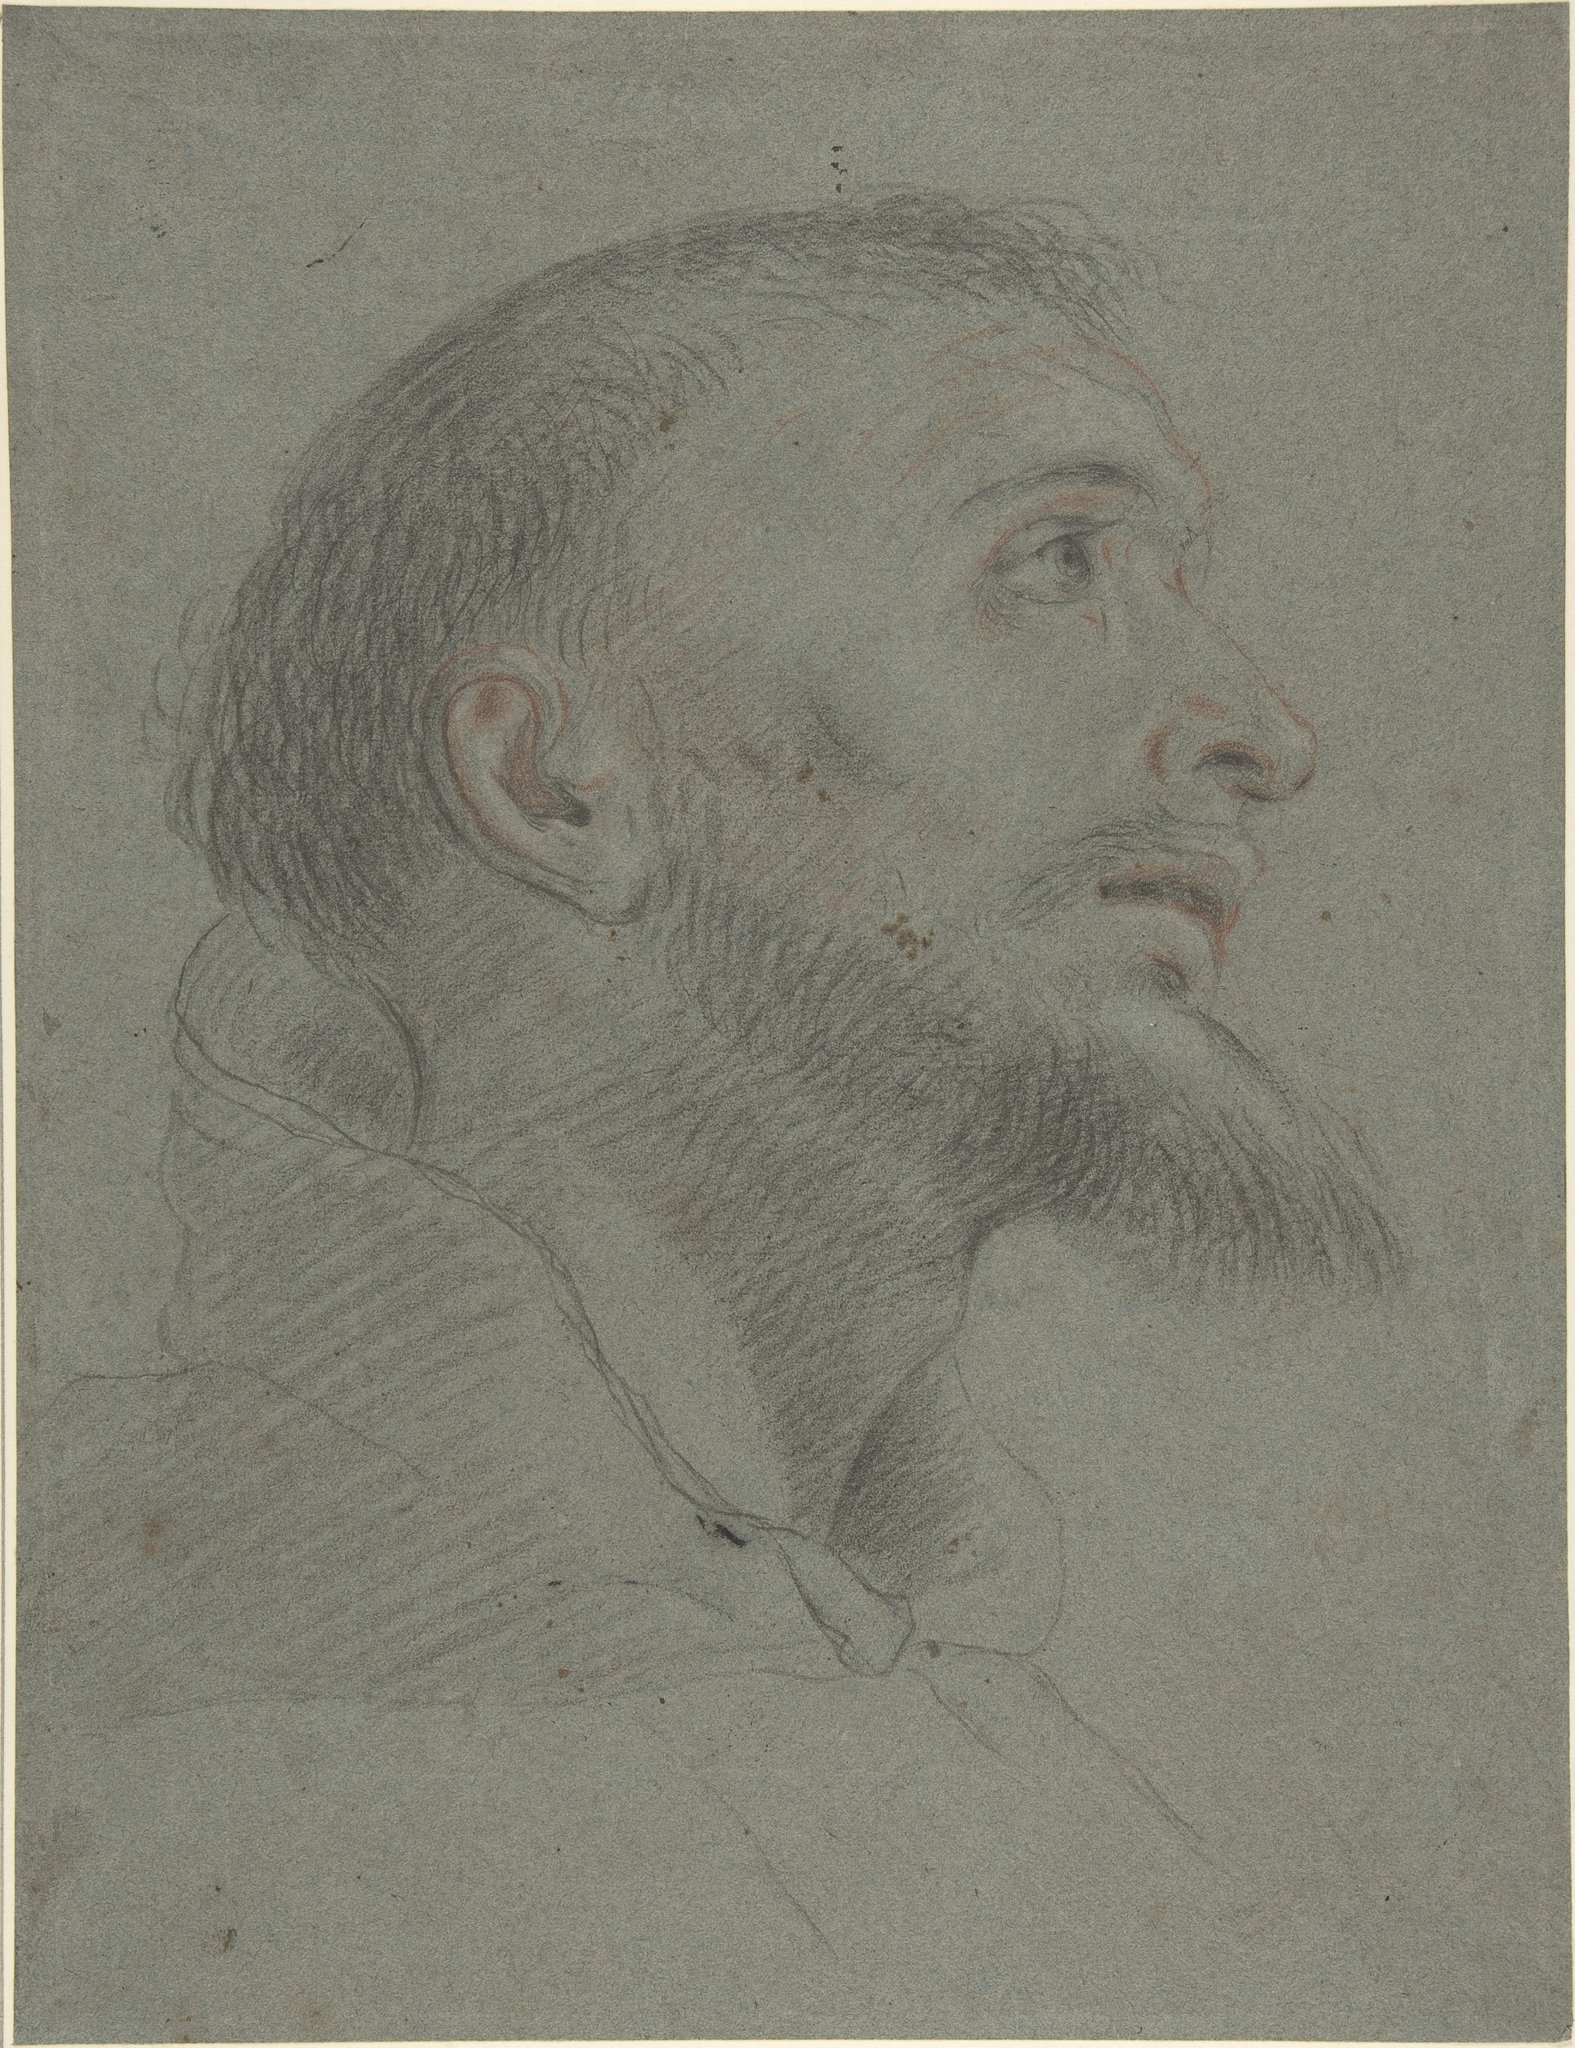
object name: drawing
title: Bust-Length Study for the Head of Saint Francis in Near Profile Facing Right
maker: anonymous, italian, bolognese, 17th century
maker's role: artist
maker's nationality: italian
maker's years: 1600-1700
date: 1601-1700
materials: chalk, paper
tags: saint francis